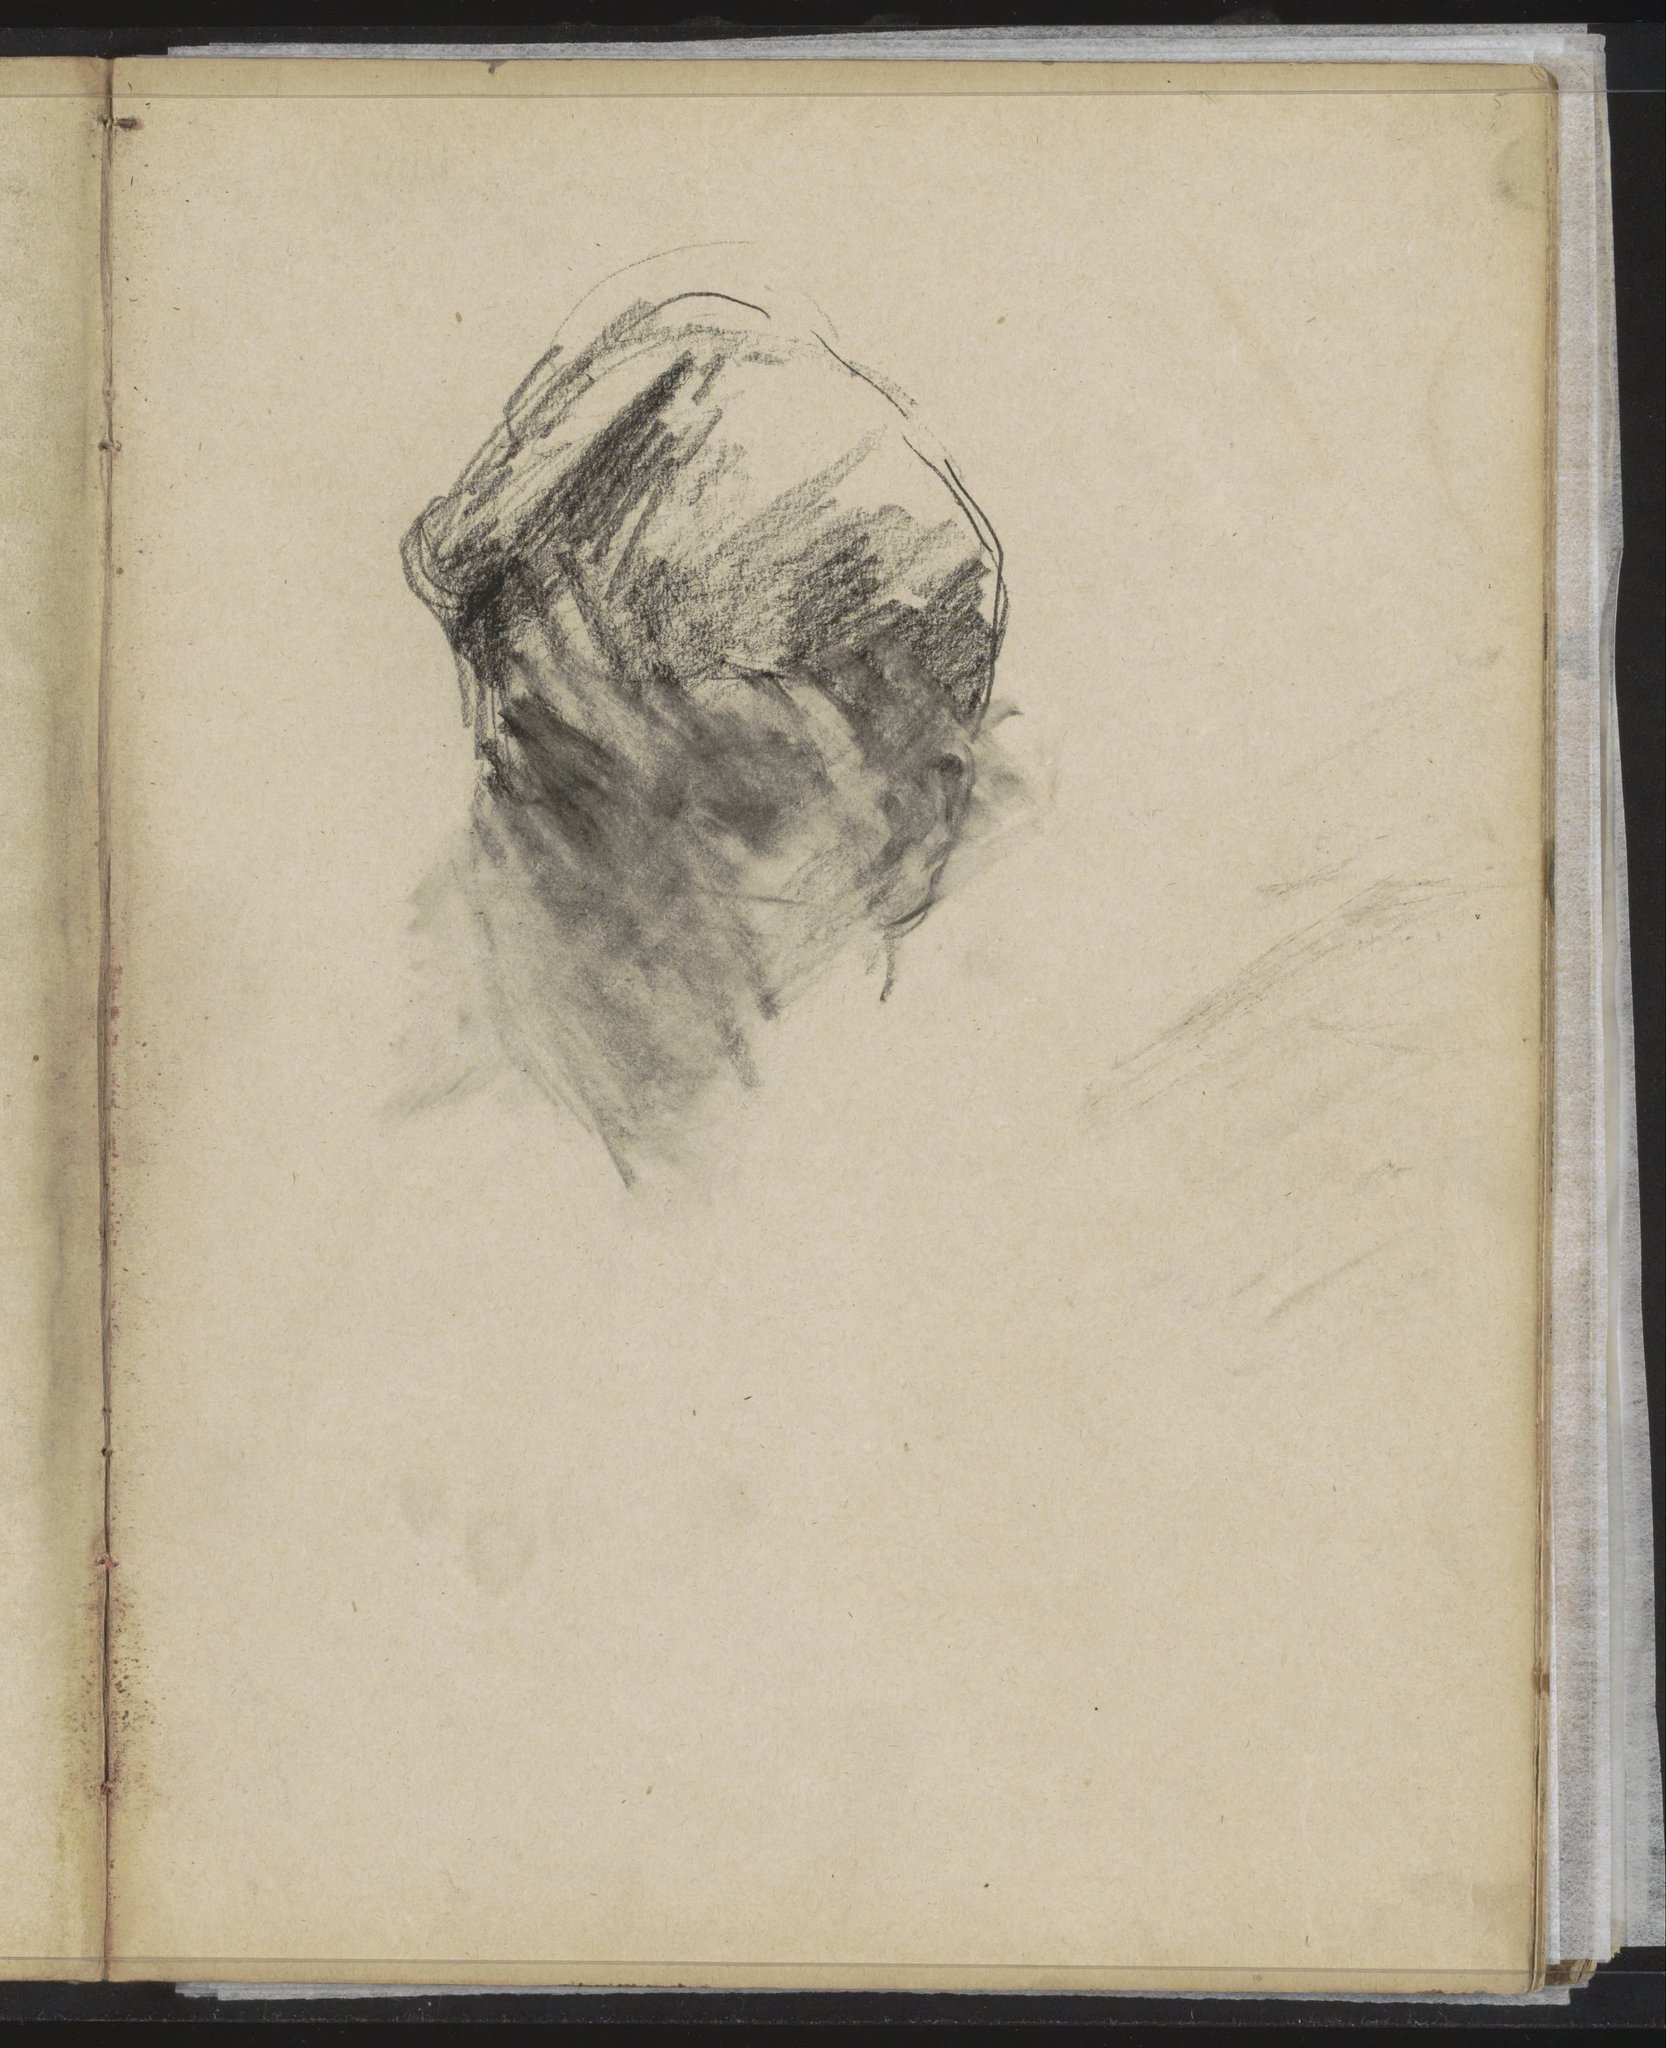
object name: sketchbook leaf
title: Hoofd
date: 1887-1891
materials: chalk, paper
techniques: stumping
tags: head (human)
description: Pagina 5 uit een schetsboek met 29 bladen.